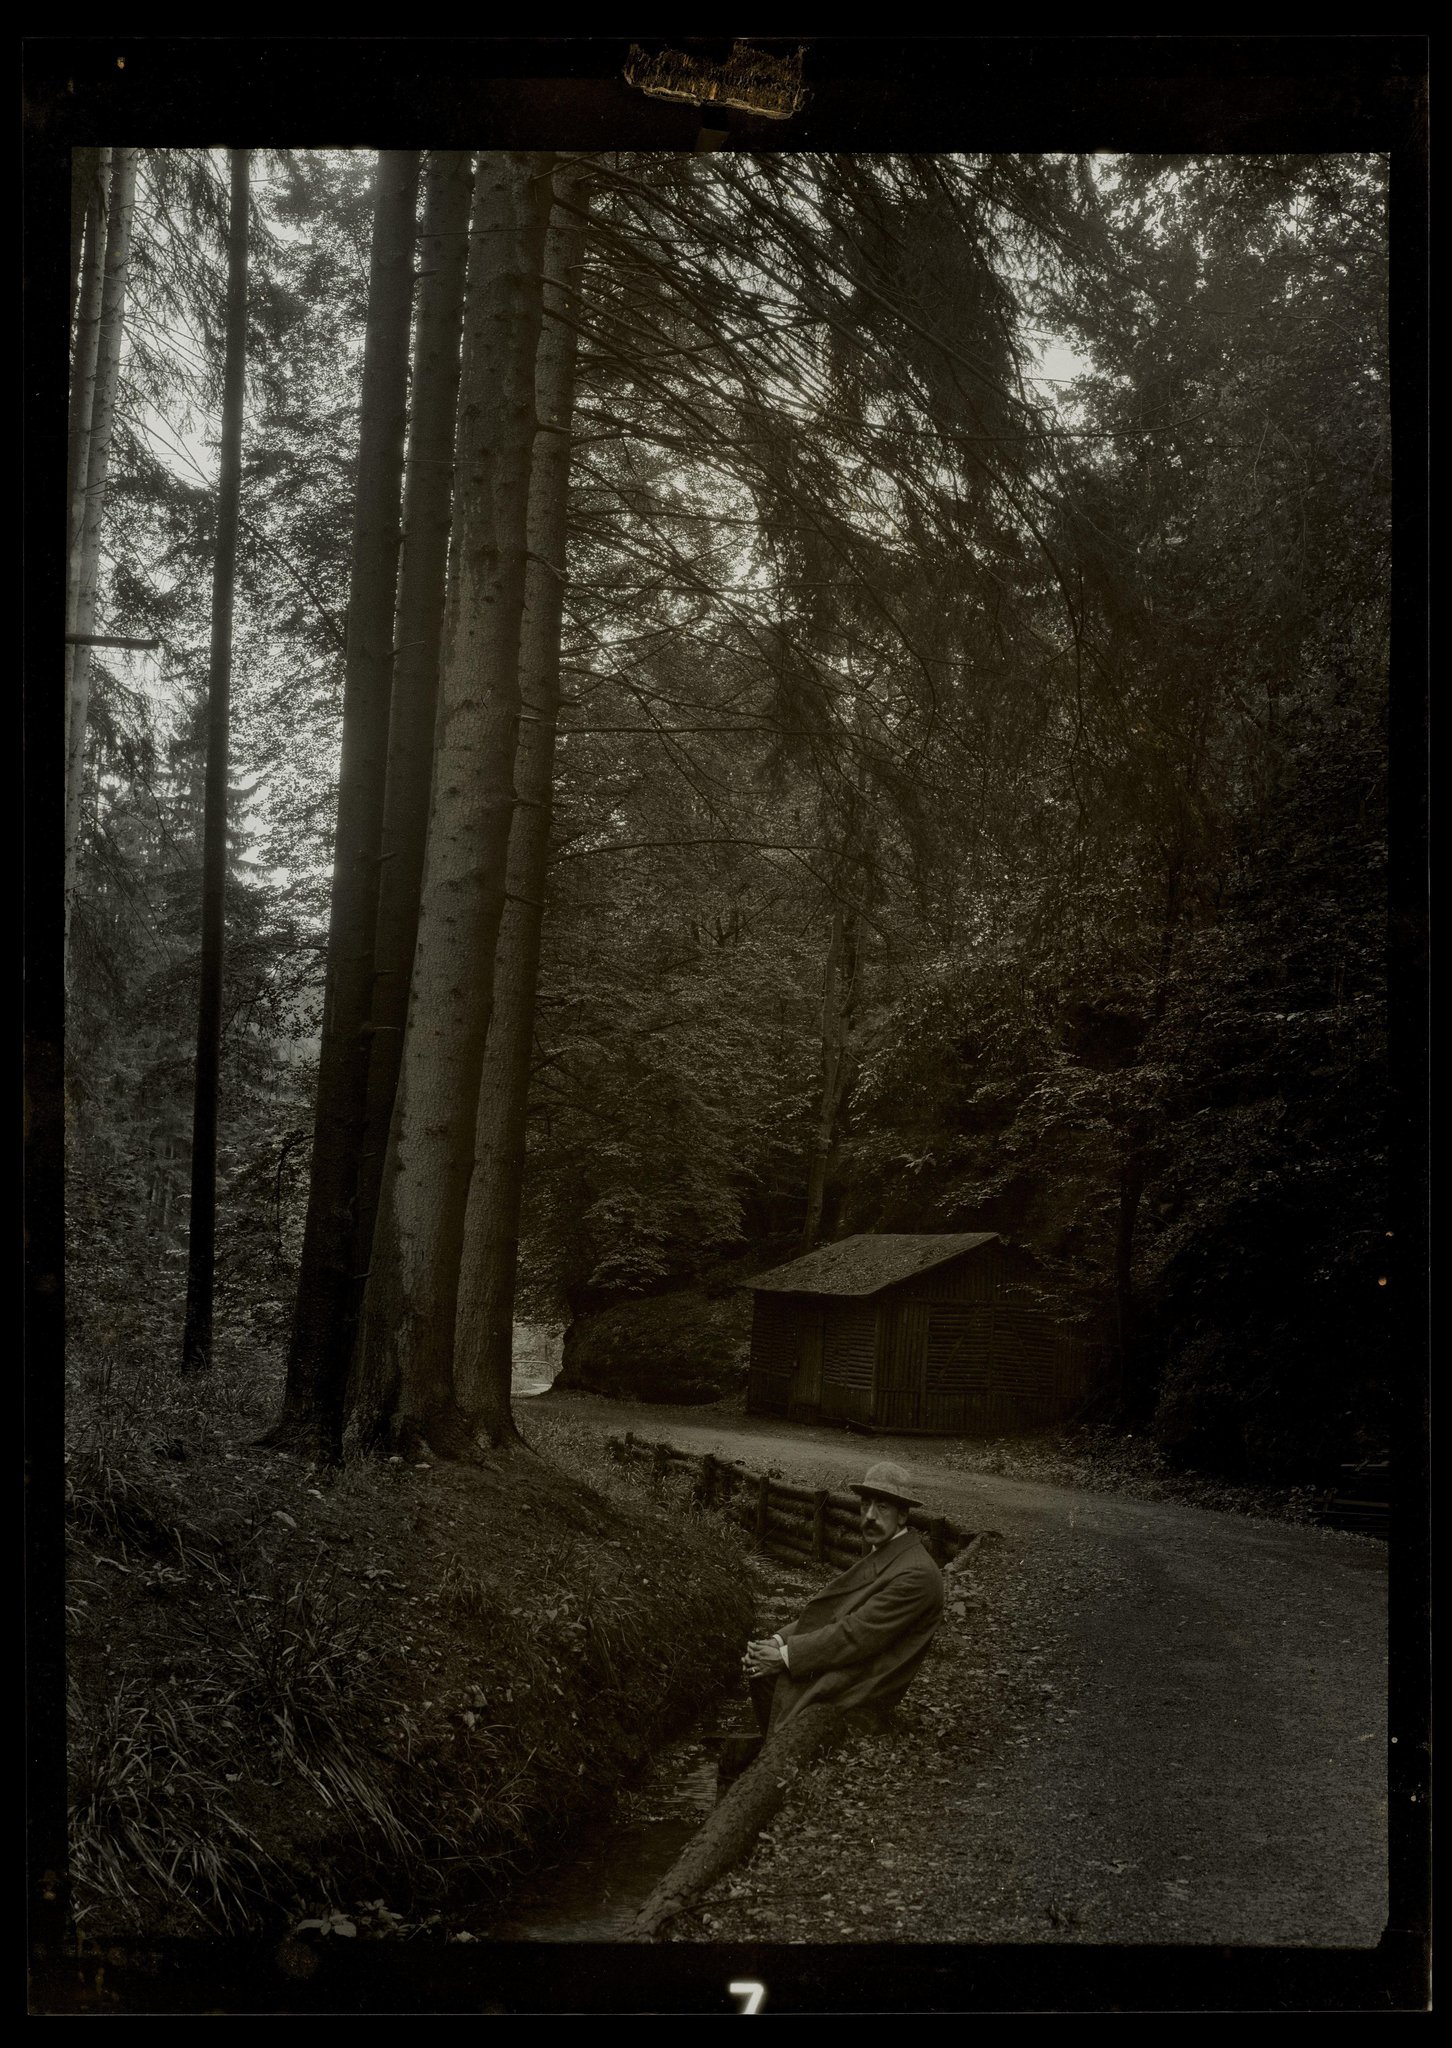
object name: photograph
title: Filmnegatief met opname van Eisenach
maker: Anonymous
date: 1921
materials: film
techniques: gelatin silver negative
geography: germany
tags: eisenach